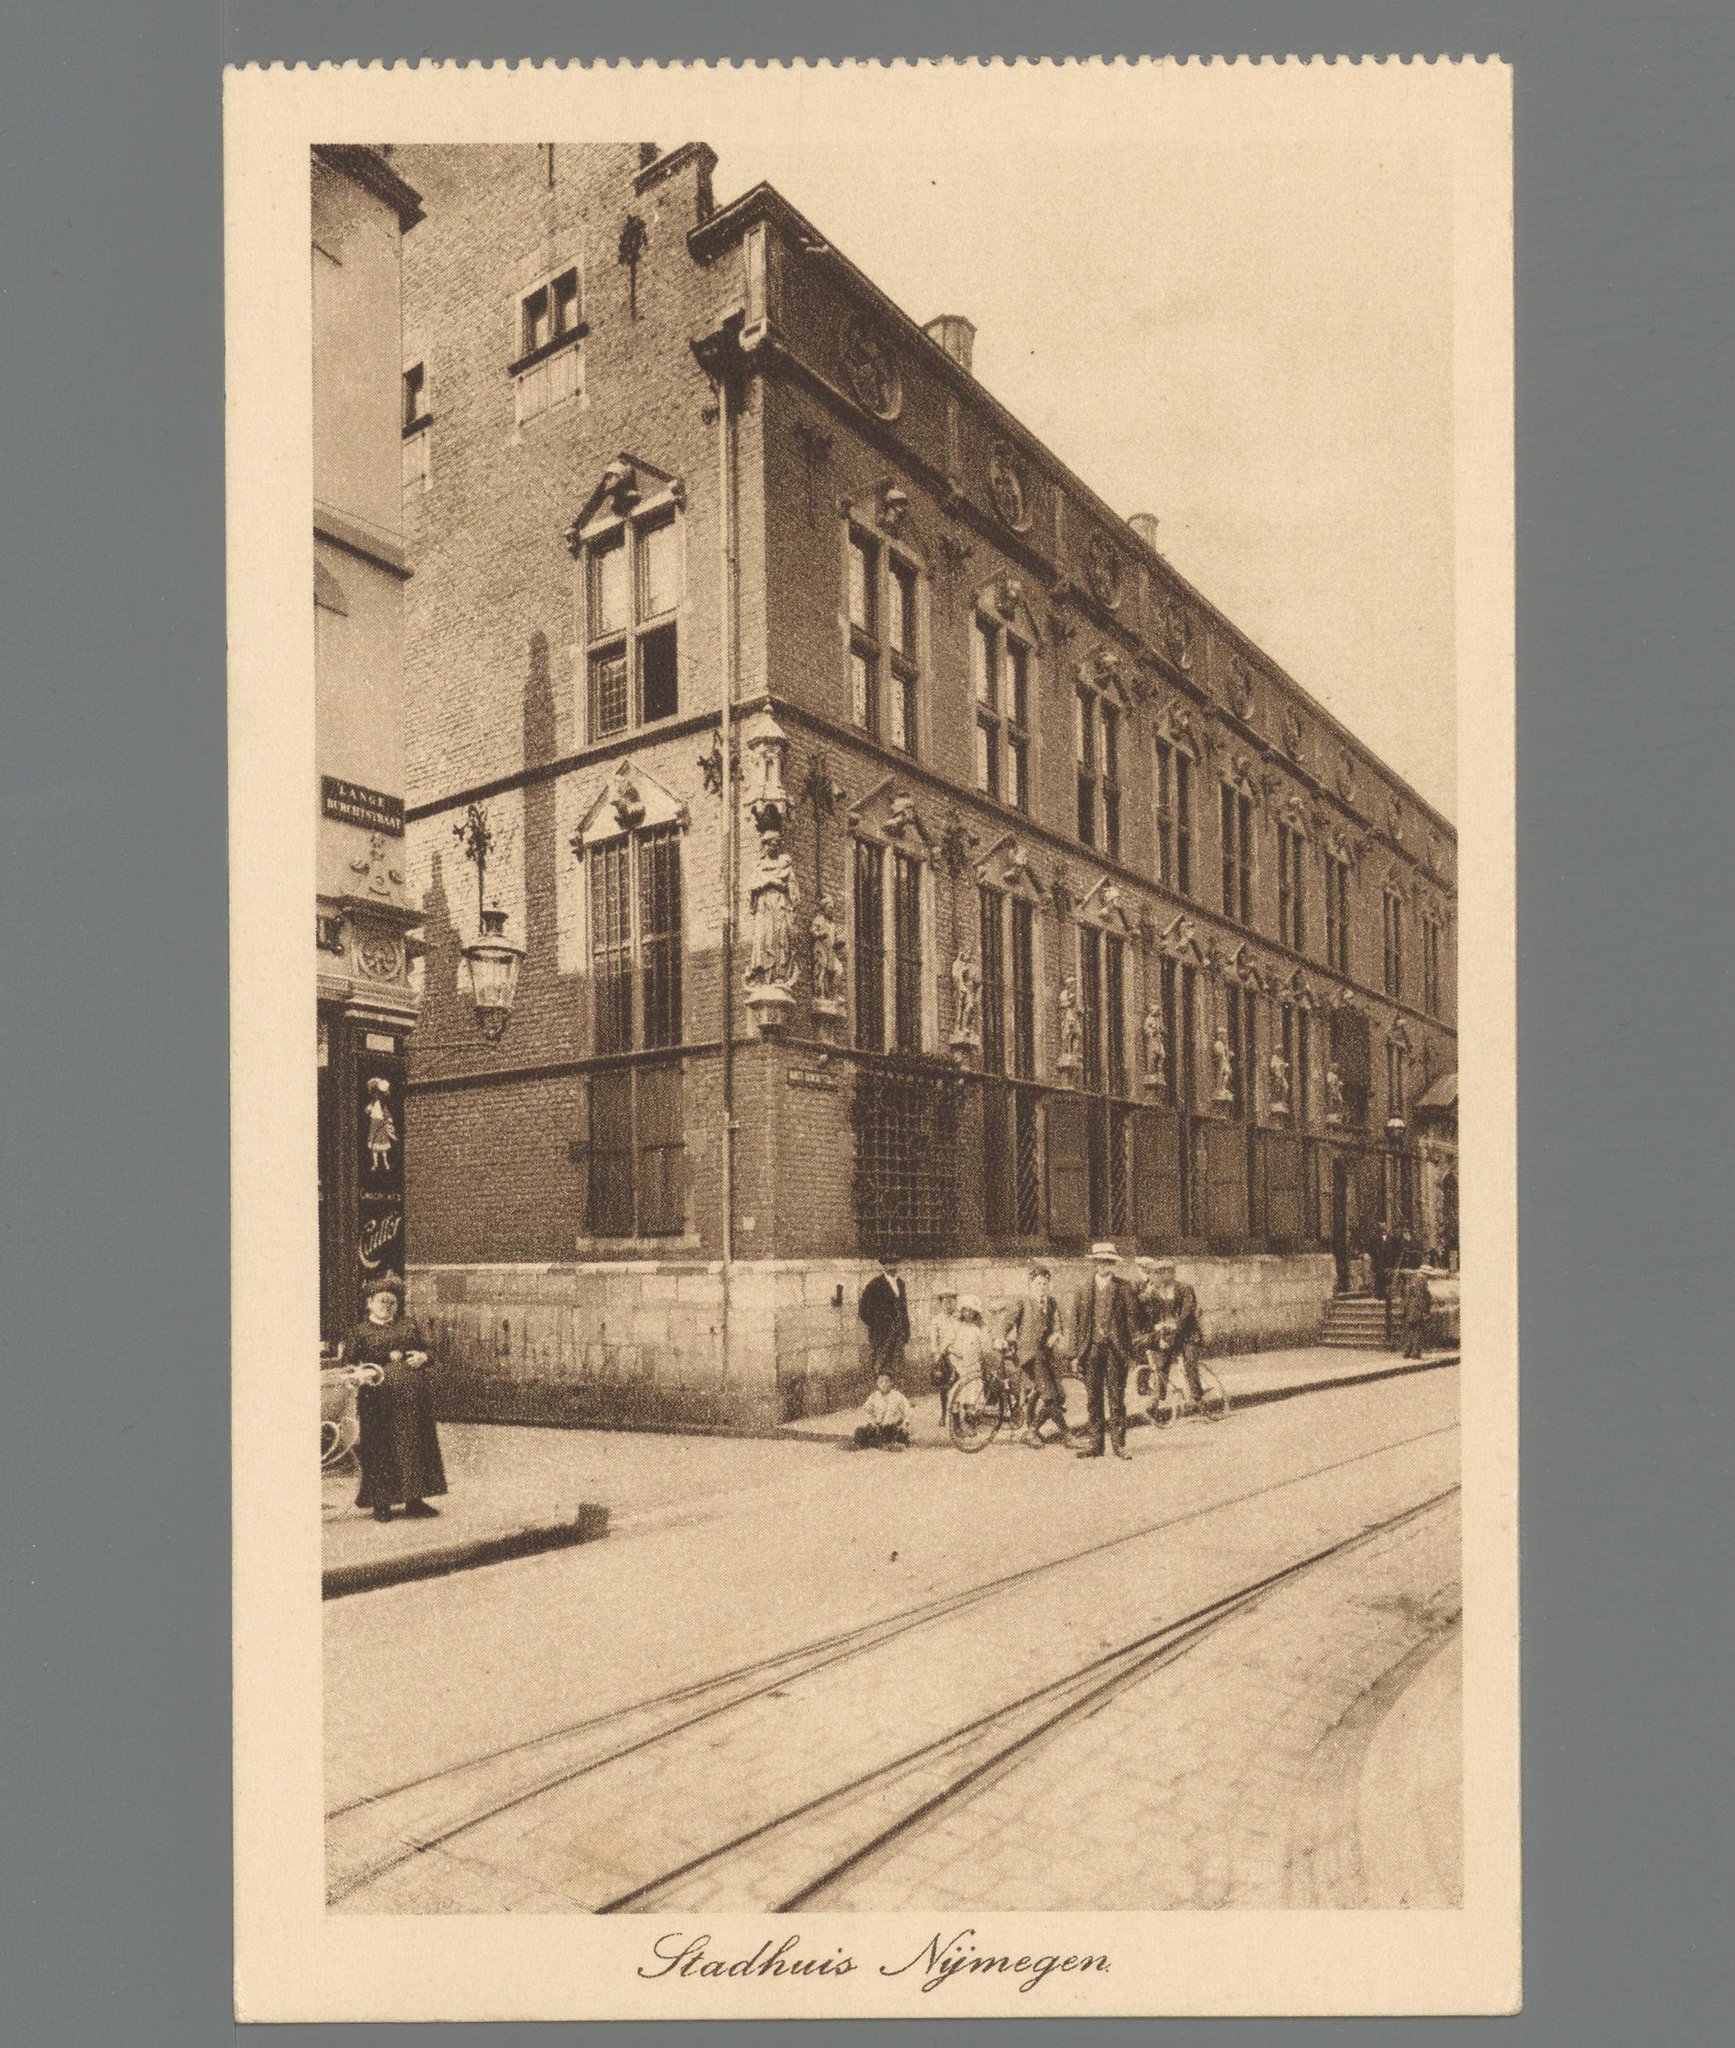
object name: ansichtkaart, prentbriefkaart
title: Stadhuis Nijmegen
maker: Anonymous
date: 1919-1930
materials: cardboard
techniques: rotogravure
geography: nijmegen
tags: townhall